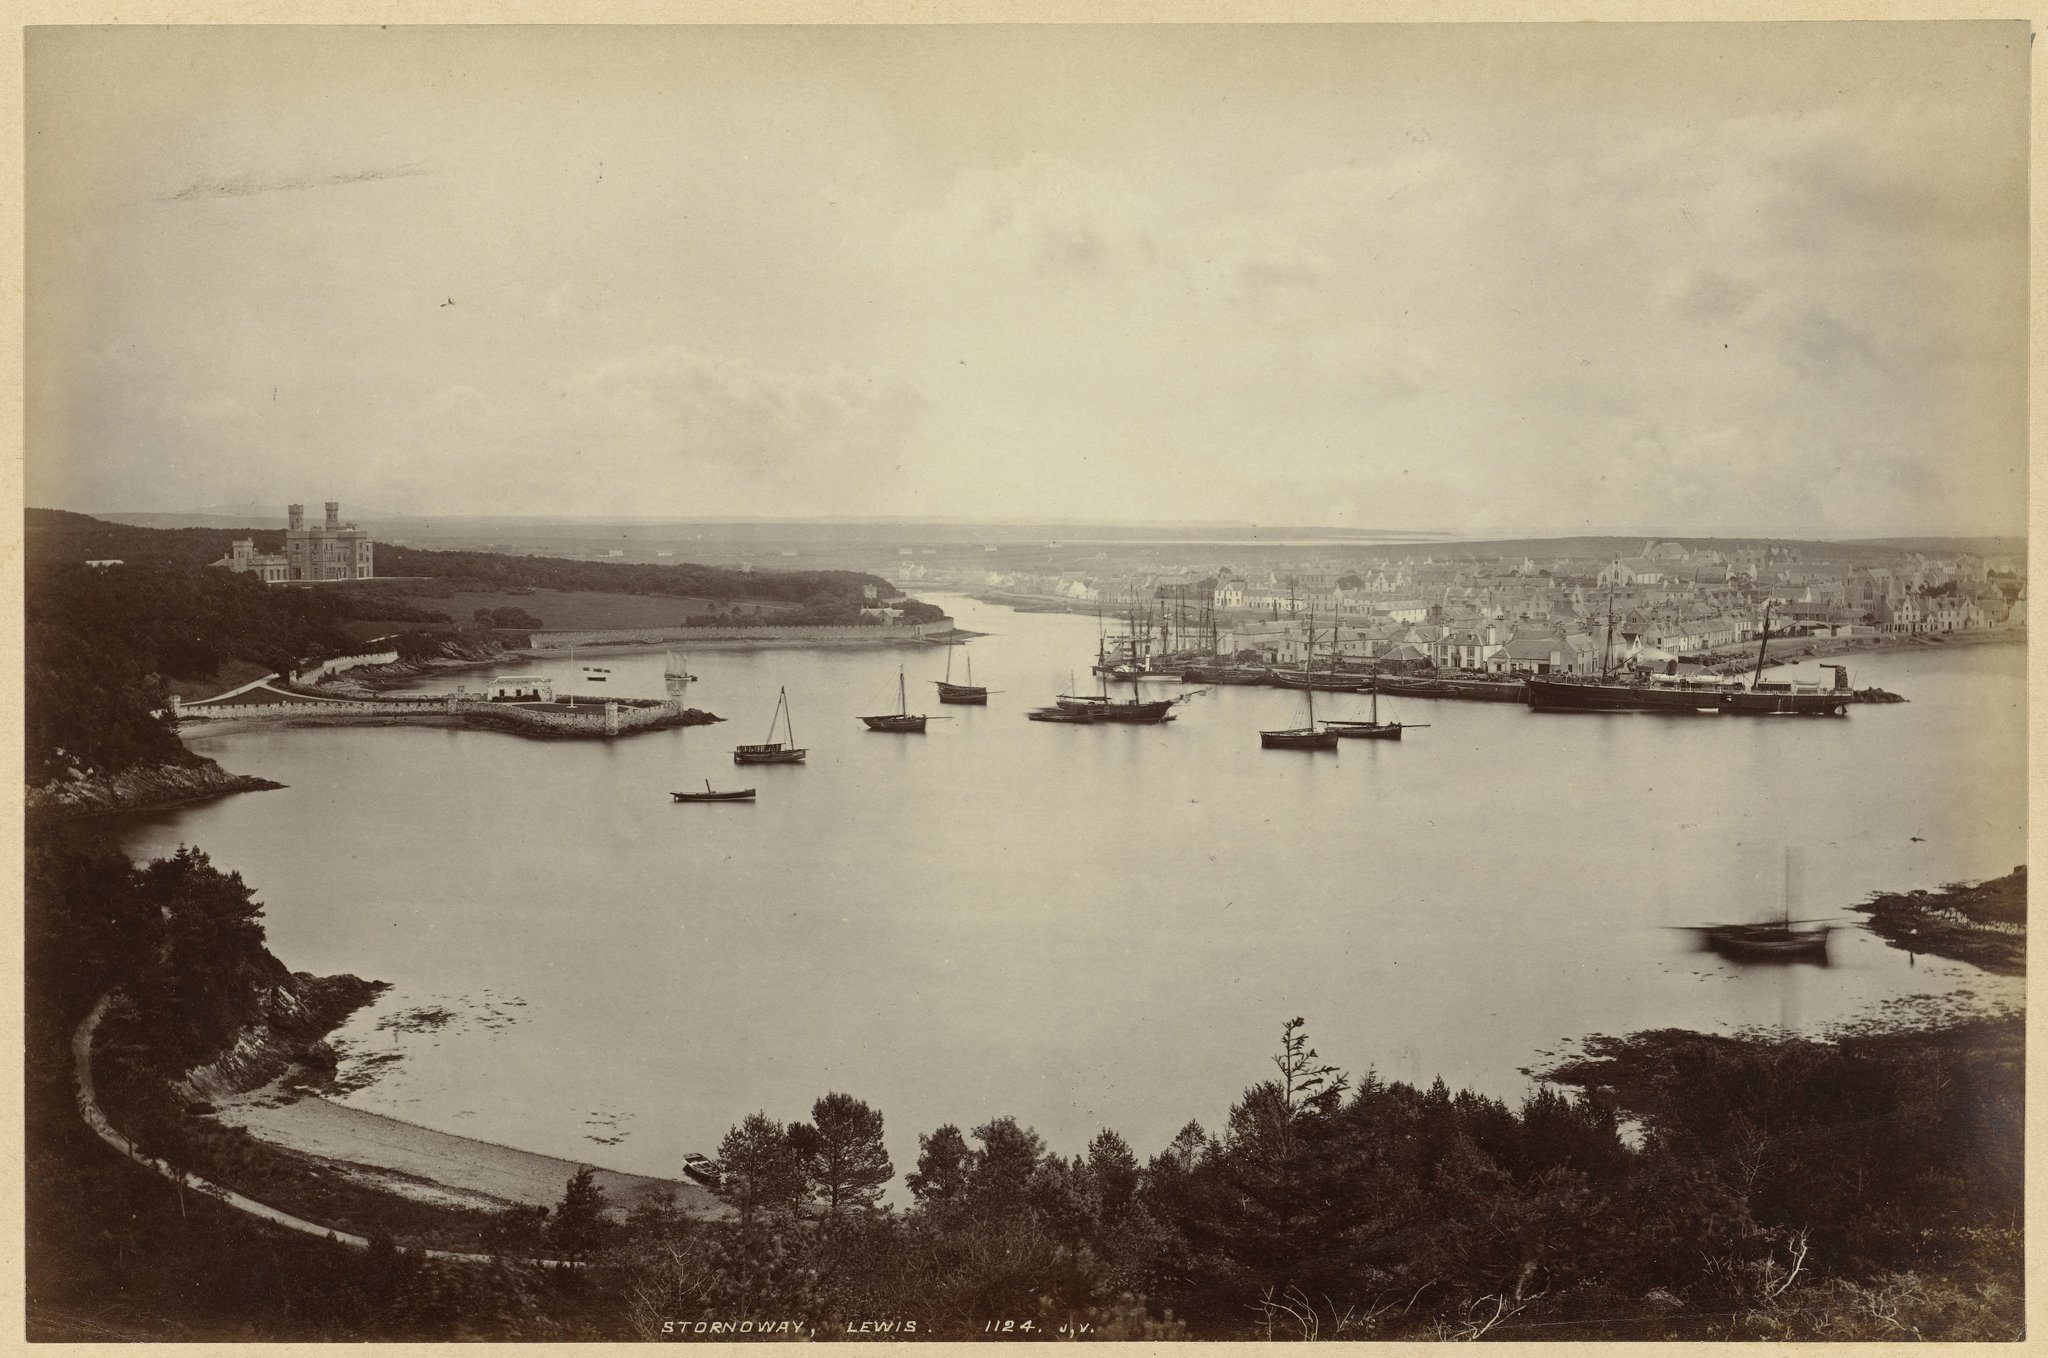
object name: photograph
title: Gezicht op Stornoway, Lewis, met links Lews Castle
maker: james valentine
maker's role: fotograaf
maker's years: 1815-1880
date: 1851-1880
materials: cardboard, paper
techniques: albumen print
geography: lewis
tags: island, city-view in general; 'veduta', castle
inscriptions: number: ‘1124.’